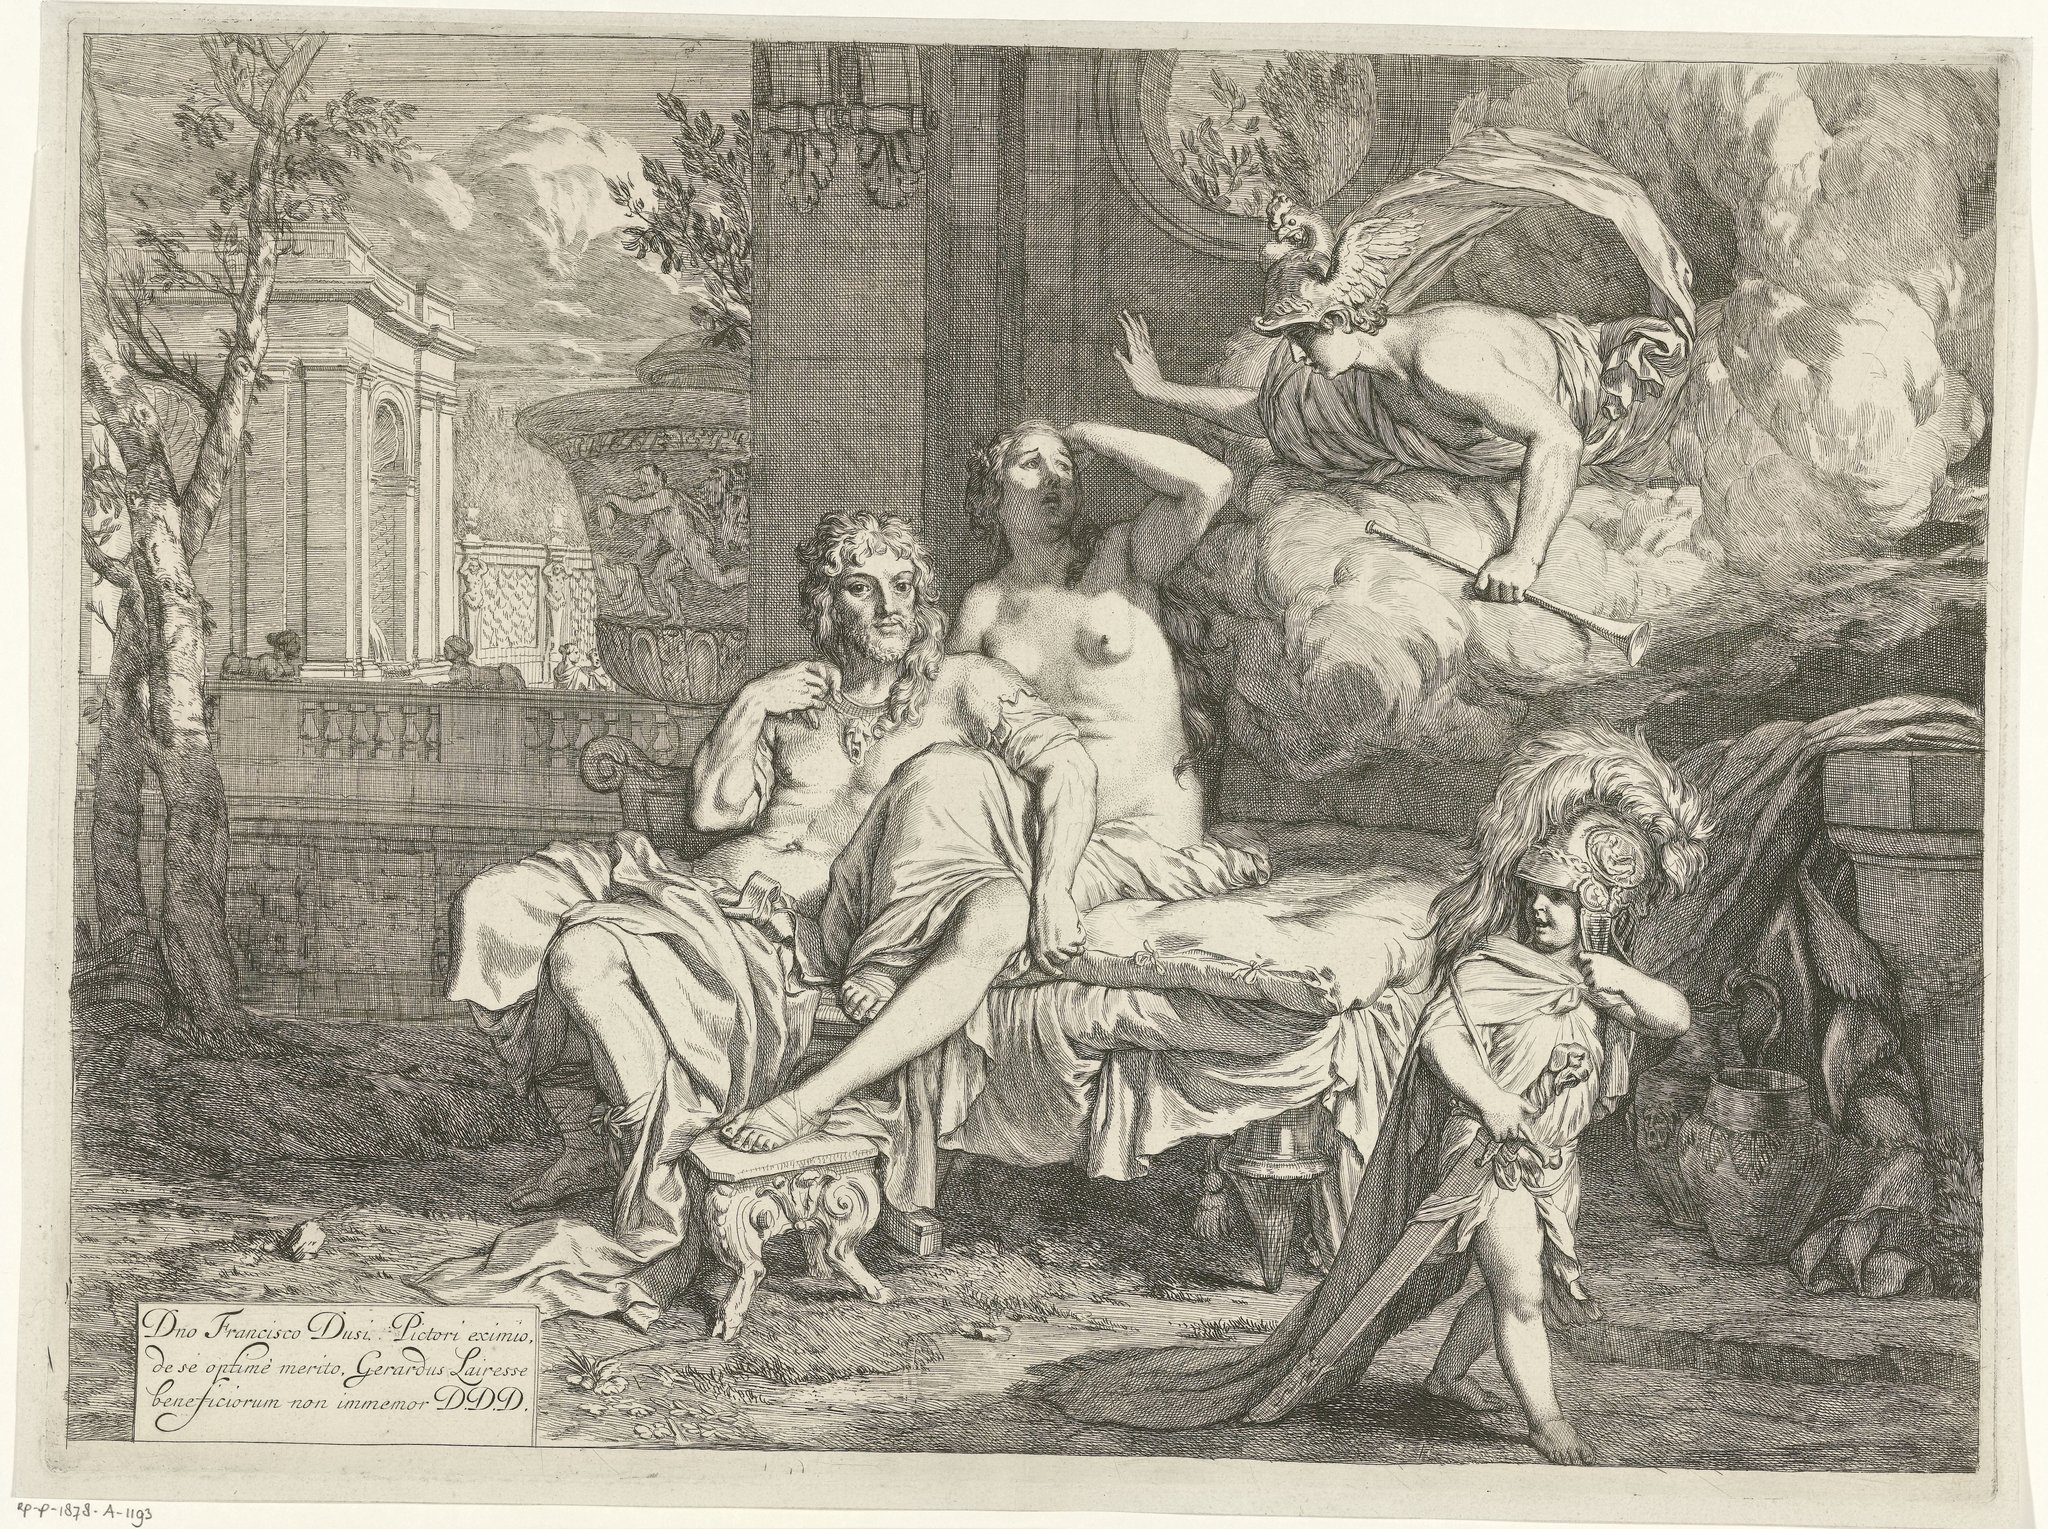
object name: print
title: Mercurius beveelt Calypso om Odysseus te laten vertrekken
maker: Anonymous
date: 1670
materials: paper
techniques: etching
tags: mercury orders calypso to release ulysses (homer, odyssey v)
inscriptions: collector's mark: Lugt 2228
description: Mercurius is in een wolk verschenen en beveelt Calypso om Odysseus te laten vertrekken. Rechts op de voorgrond poseert Amor met de helm en het zwaard van Odysseus.